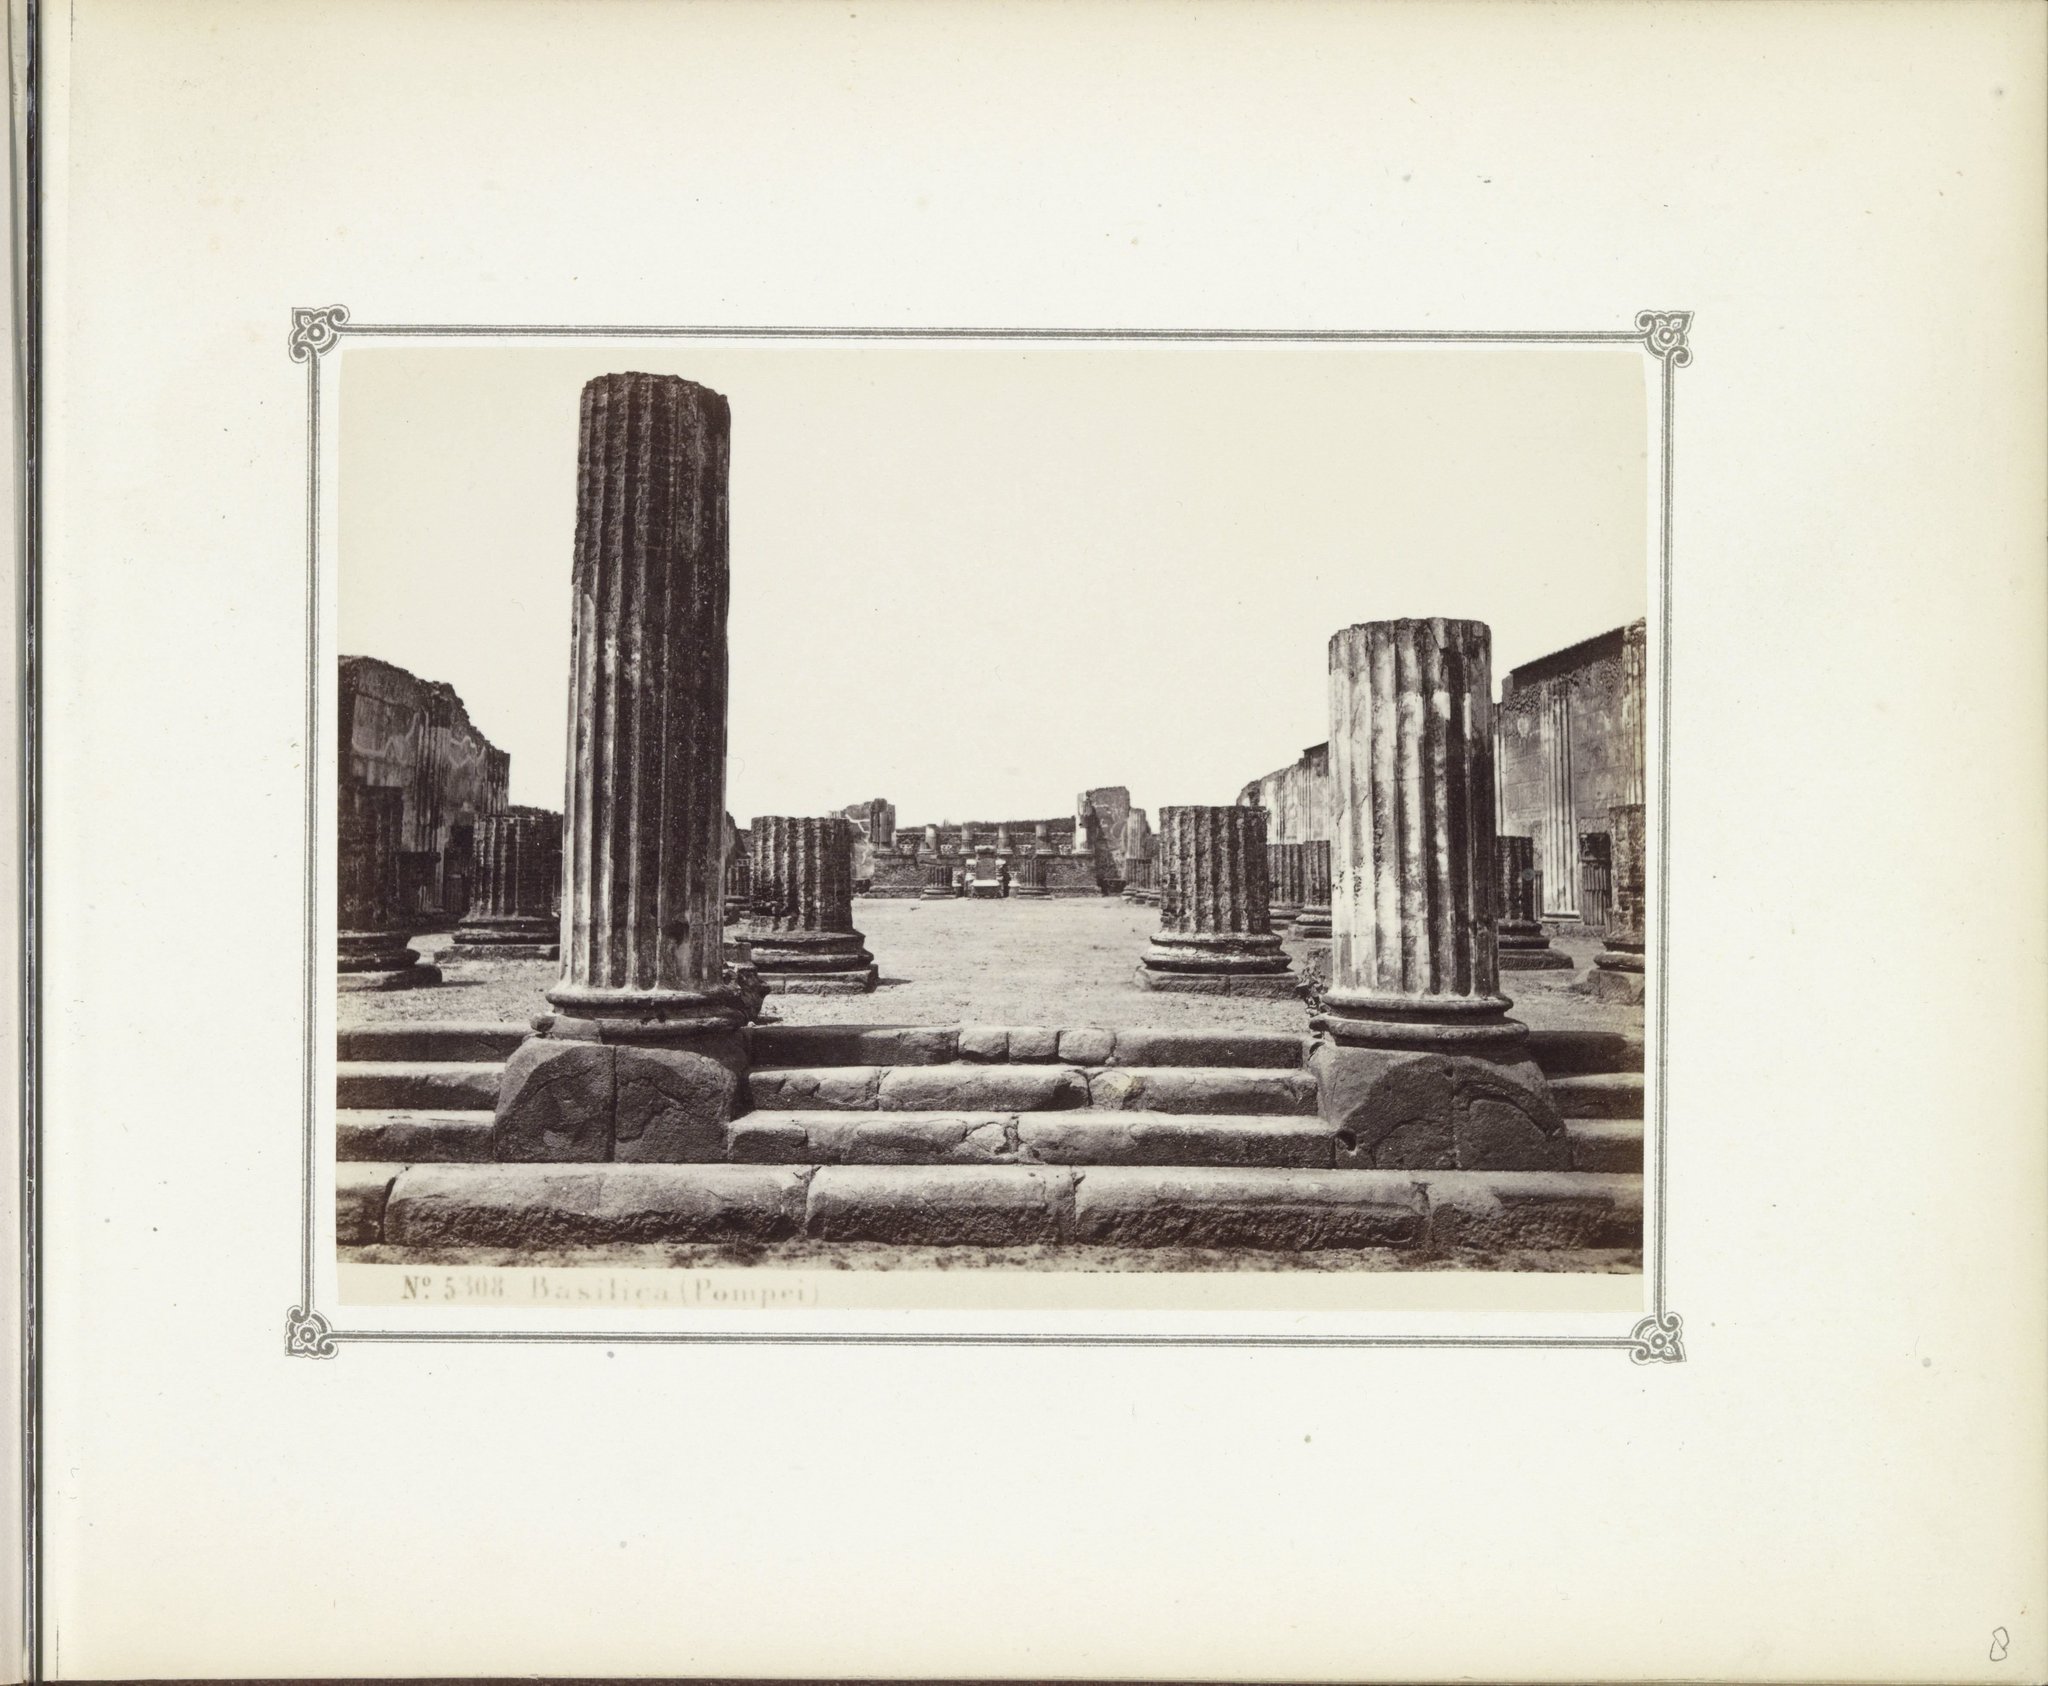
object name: photograph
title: Basilica. (Pompei.)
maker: giorgio sommer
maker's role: fotograaf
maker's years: 1834-1914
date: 1860-1900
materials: paper, photographic support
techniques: albumen print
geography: pompeii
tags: excavation ~ archaeology, pompeii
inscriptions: number: ‘5308’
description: Onderdeel van Fotoalbum met opnames van opgravingen in Pompeï door Giorgio Sommer.